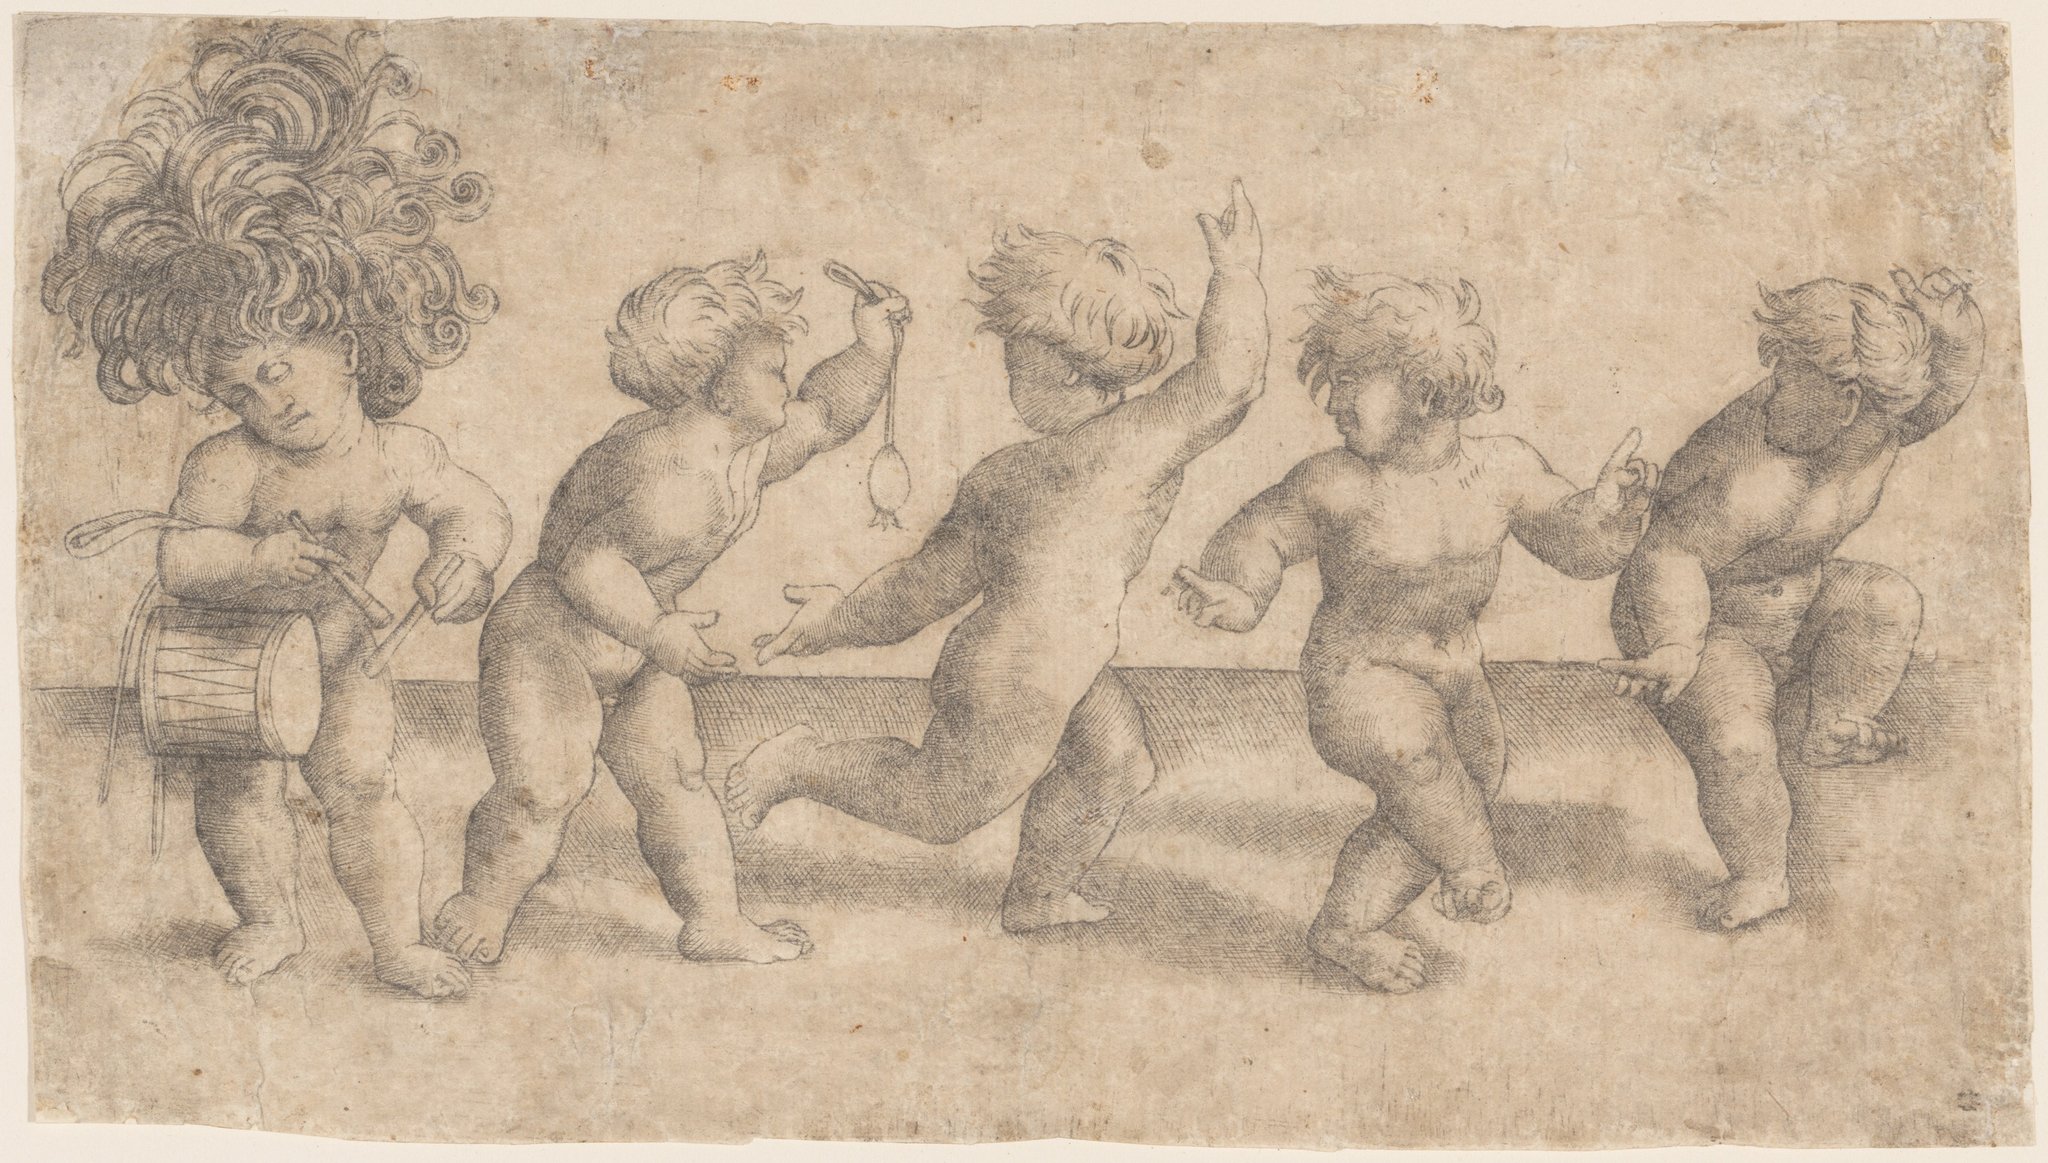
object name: print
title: Five Dancing Putti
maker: amico aspertini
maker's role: artist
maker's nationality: italian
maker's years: 1474-1552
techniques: engraving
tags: dancing,drums,putti